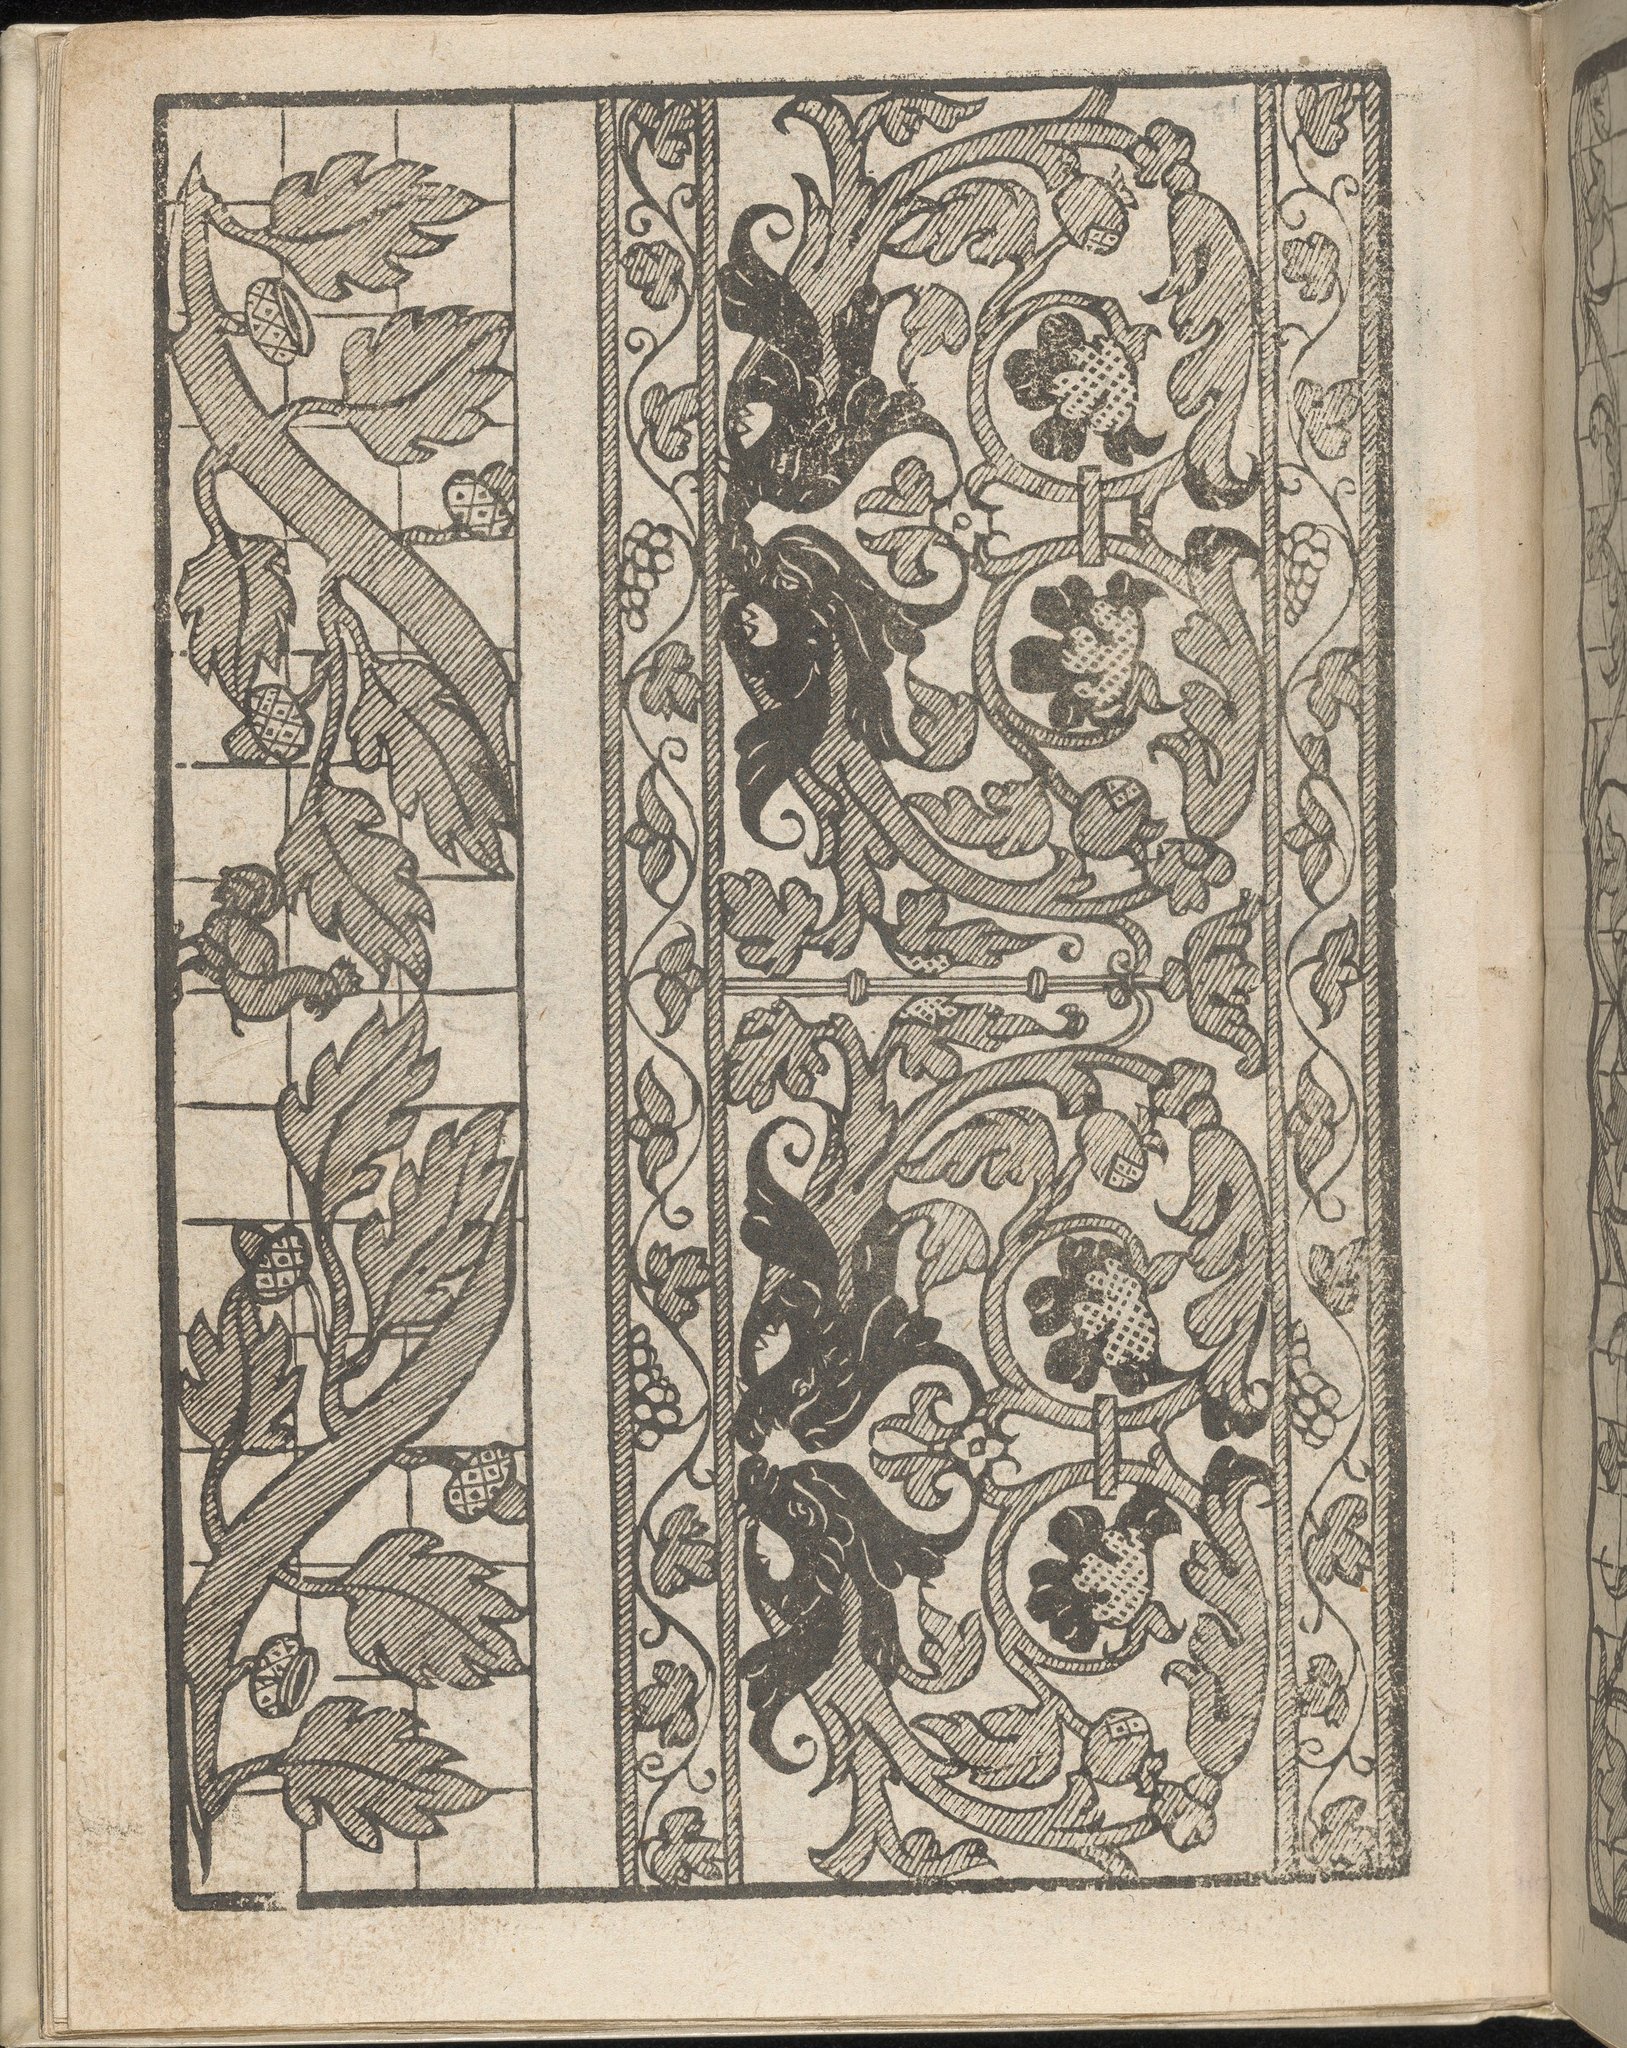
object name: book print ornament architecture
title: Lucidario di Recami, page 11 (verso)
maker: iseppo foresto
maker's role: designer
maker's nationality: italian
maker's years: 1520-1580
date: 1564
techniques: woodcut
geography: italy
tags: dolphins,flowers,vines